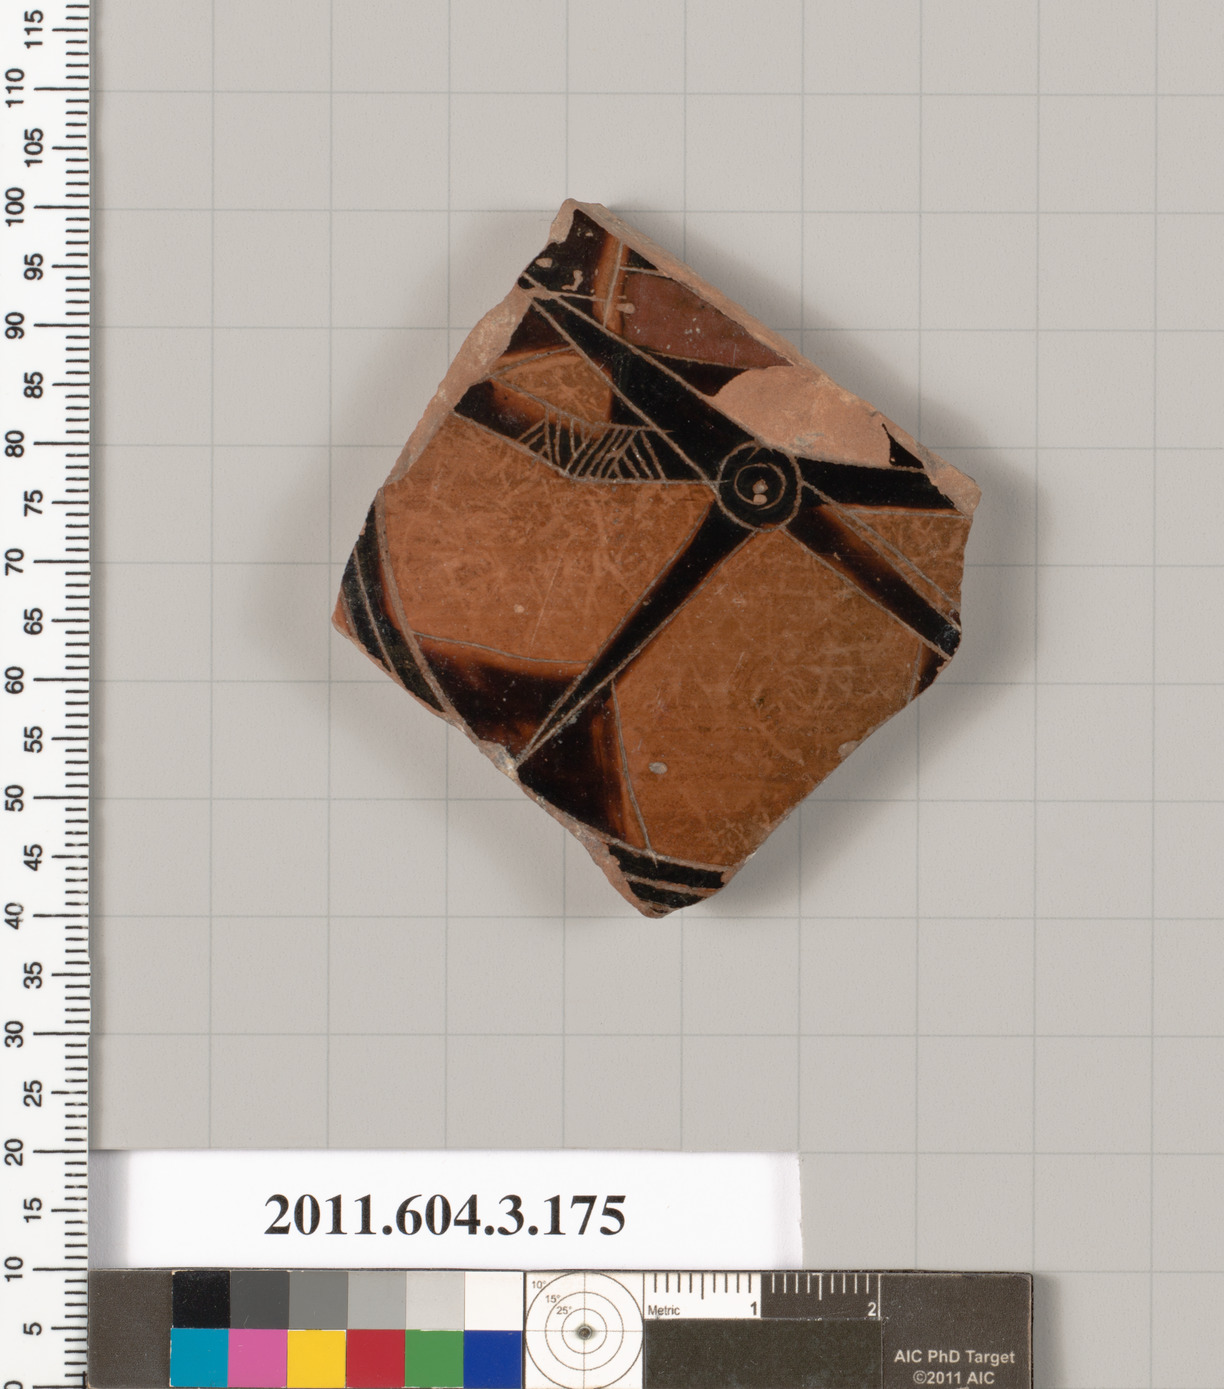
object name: amphora fragment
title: Terracotta fragment of an amphora (jar)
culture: greek, attic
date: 530-520 BCE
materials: terracotta